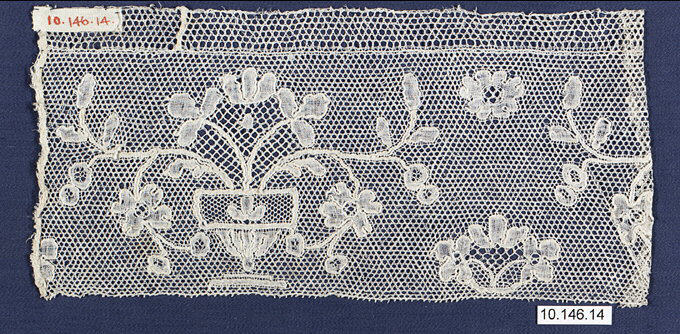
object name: fragment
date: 1701-1800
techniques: lace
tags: flowers,leaves